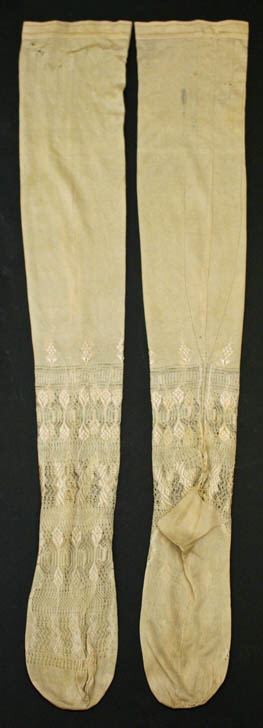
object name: wedding stocking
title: Wedding stockings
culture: american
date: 1834-1866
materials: silk